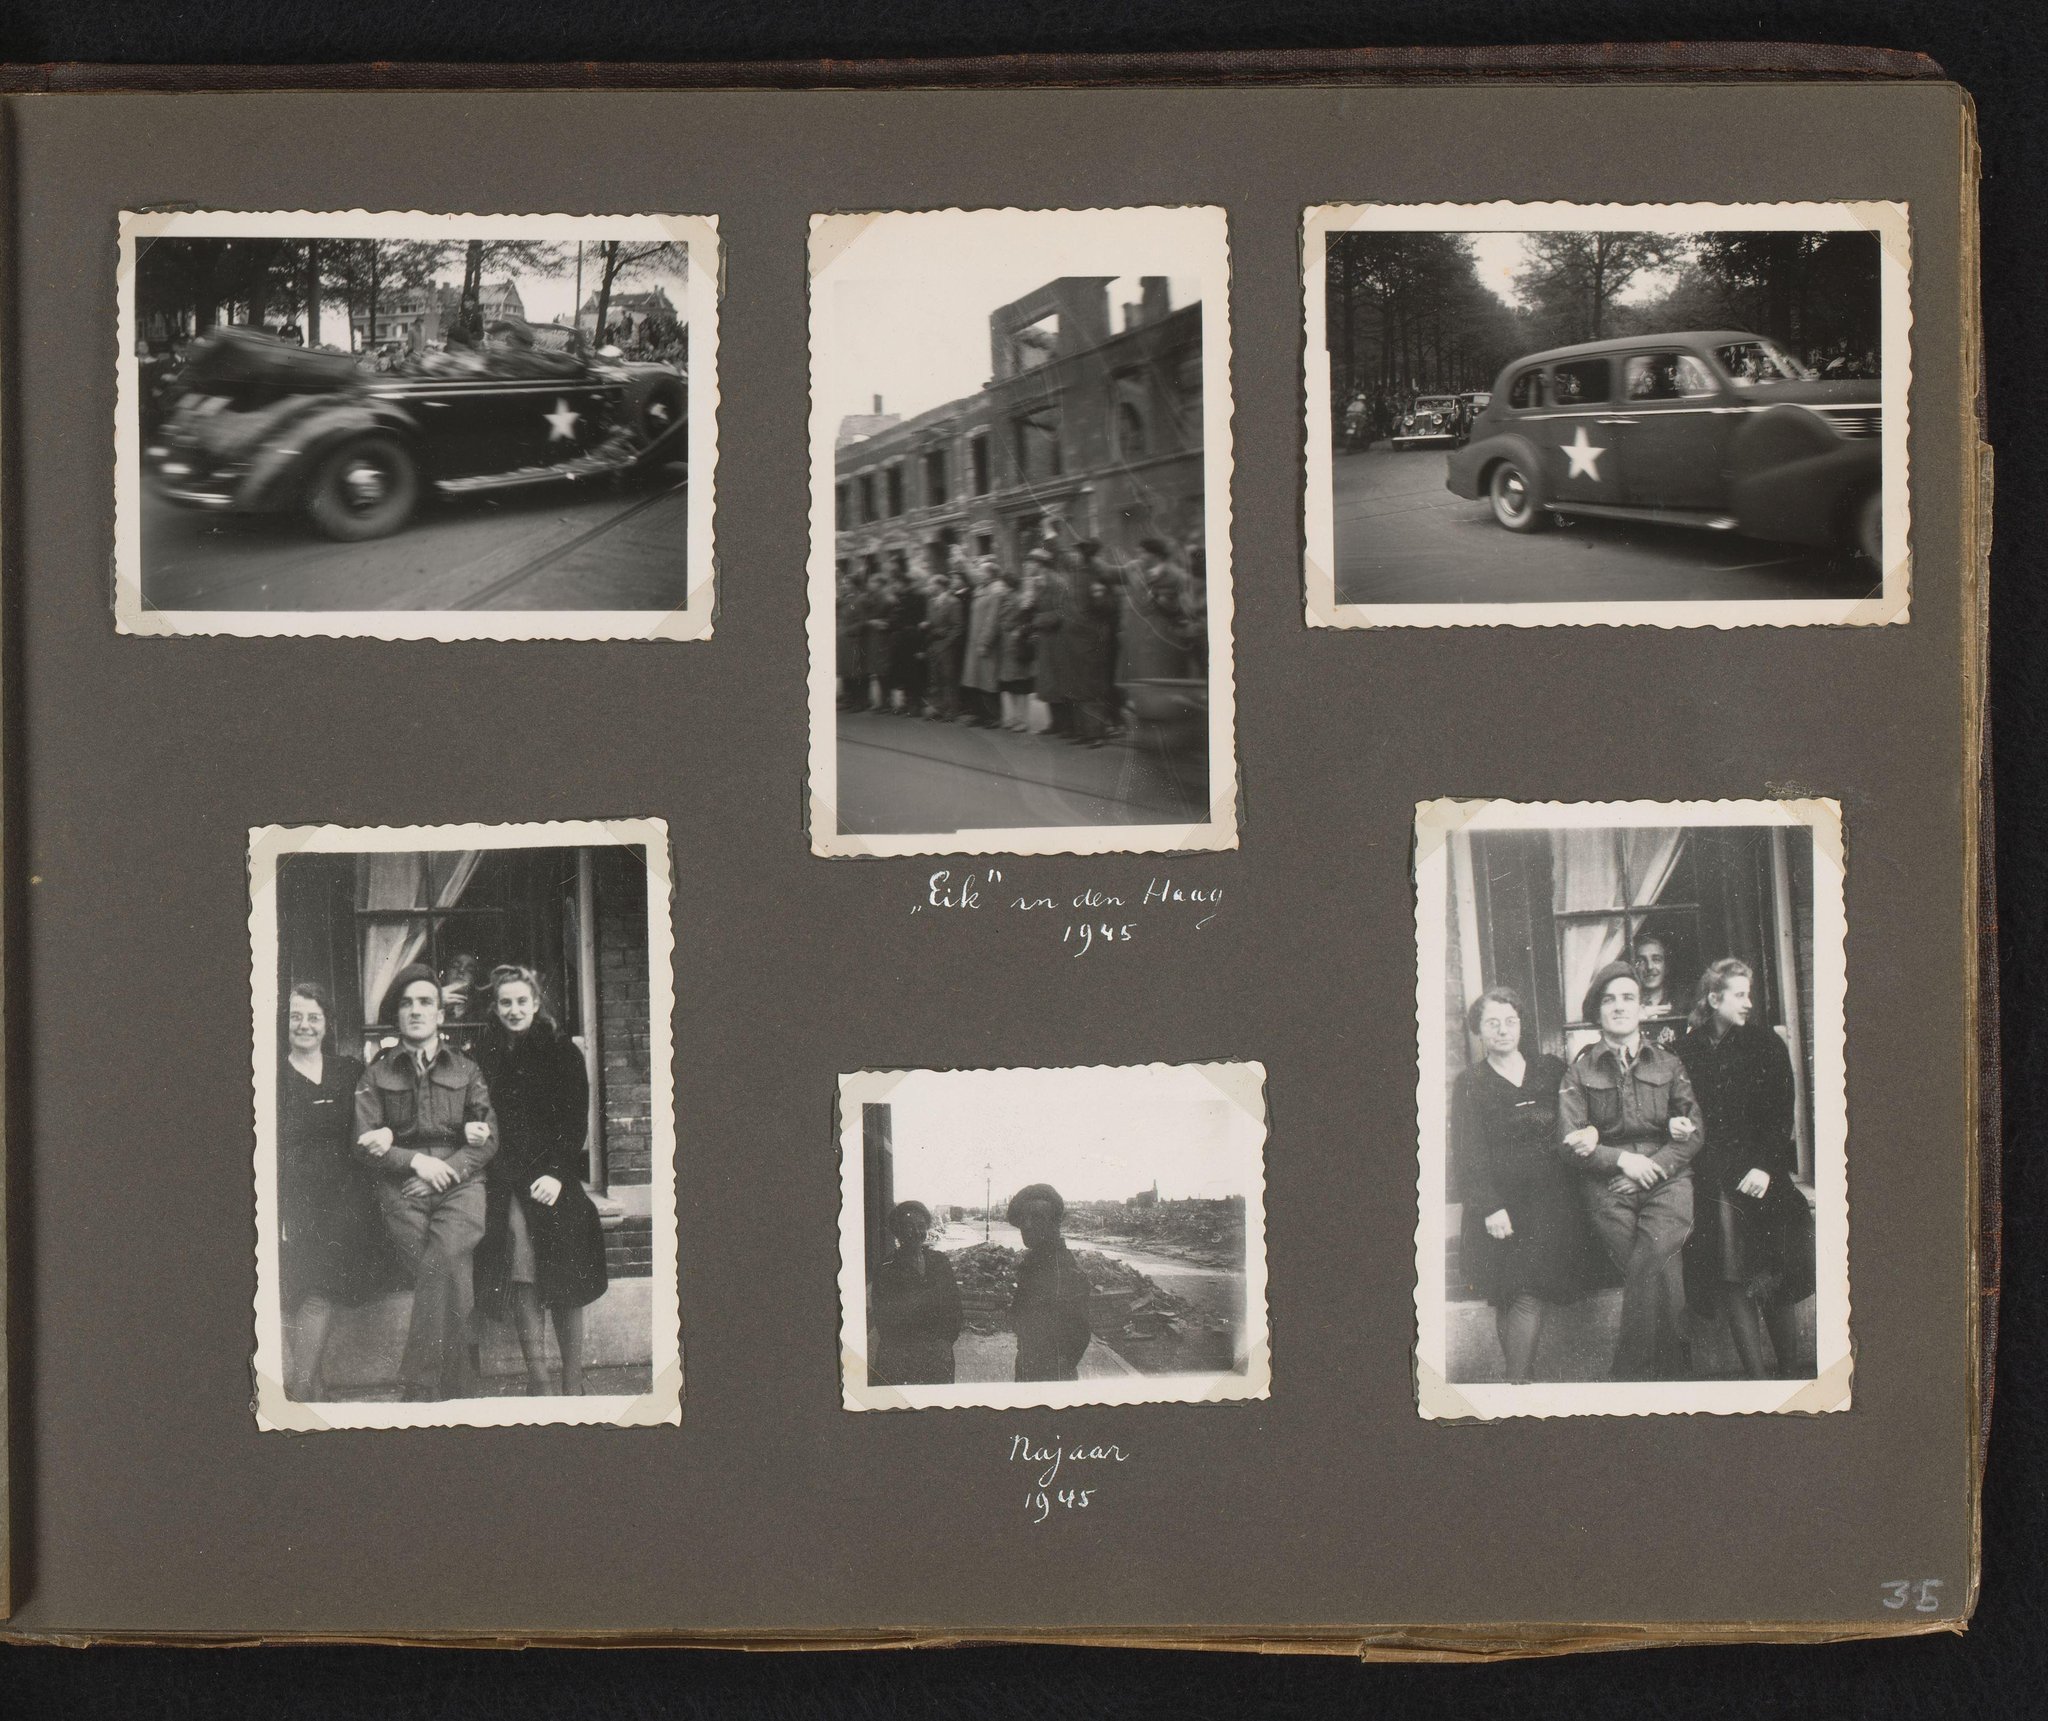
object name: photograph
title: Eisenhower in Den Haag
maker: Anonymous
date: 1910-1945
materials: paper, photographic support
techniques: gelatin silver print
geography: the hague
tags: triumphal entry and public reception, pageant, 'entrée solennelle', 'joyeuse entrée', conqueror triumphing, triumphal entry of victor, automobile, the hague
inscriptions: inscription: ‘"Eik" in den Haag 1945 / Najaar 1945’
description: Albumblad met zes foto's. Drie foto's van het bezoek van generaal Eisenhower aan Den Haag op 6 oktober 1945 en drie foto's samen met Martin O'Brienn in najaar 1945. Onderdeel van het Familiealbum 1940-1947.